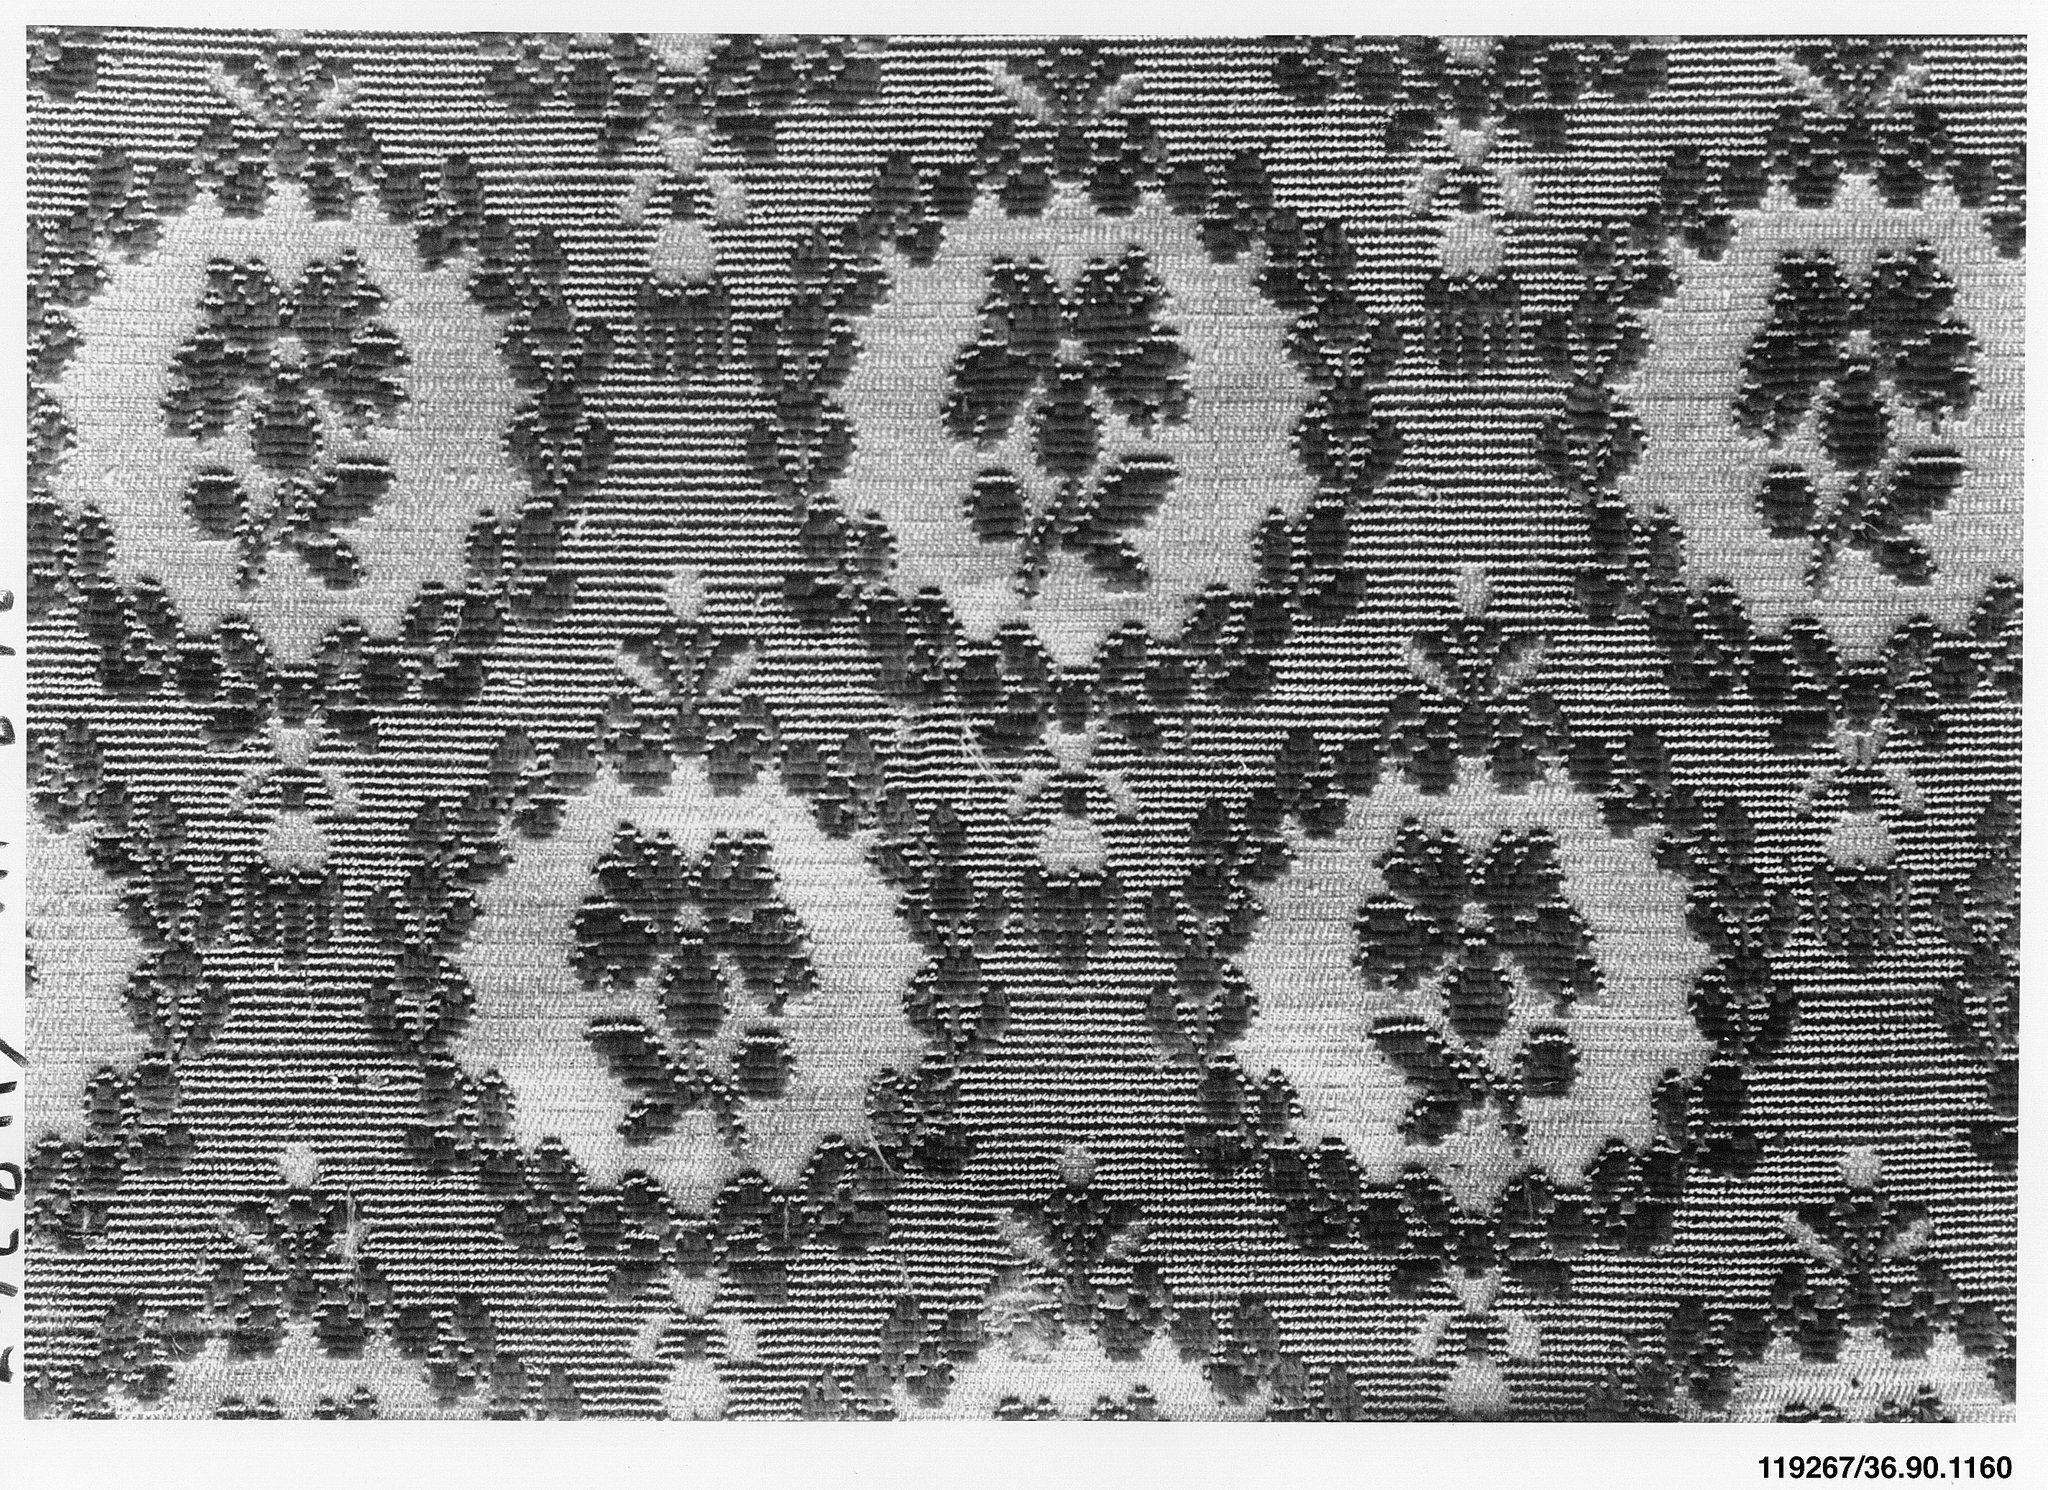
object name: piece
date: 1701-1800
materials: silk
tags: flowers